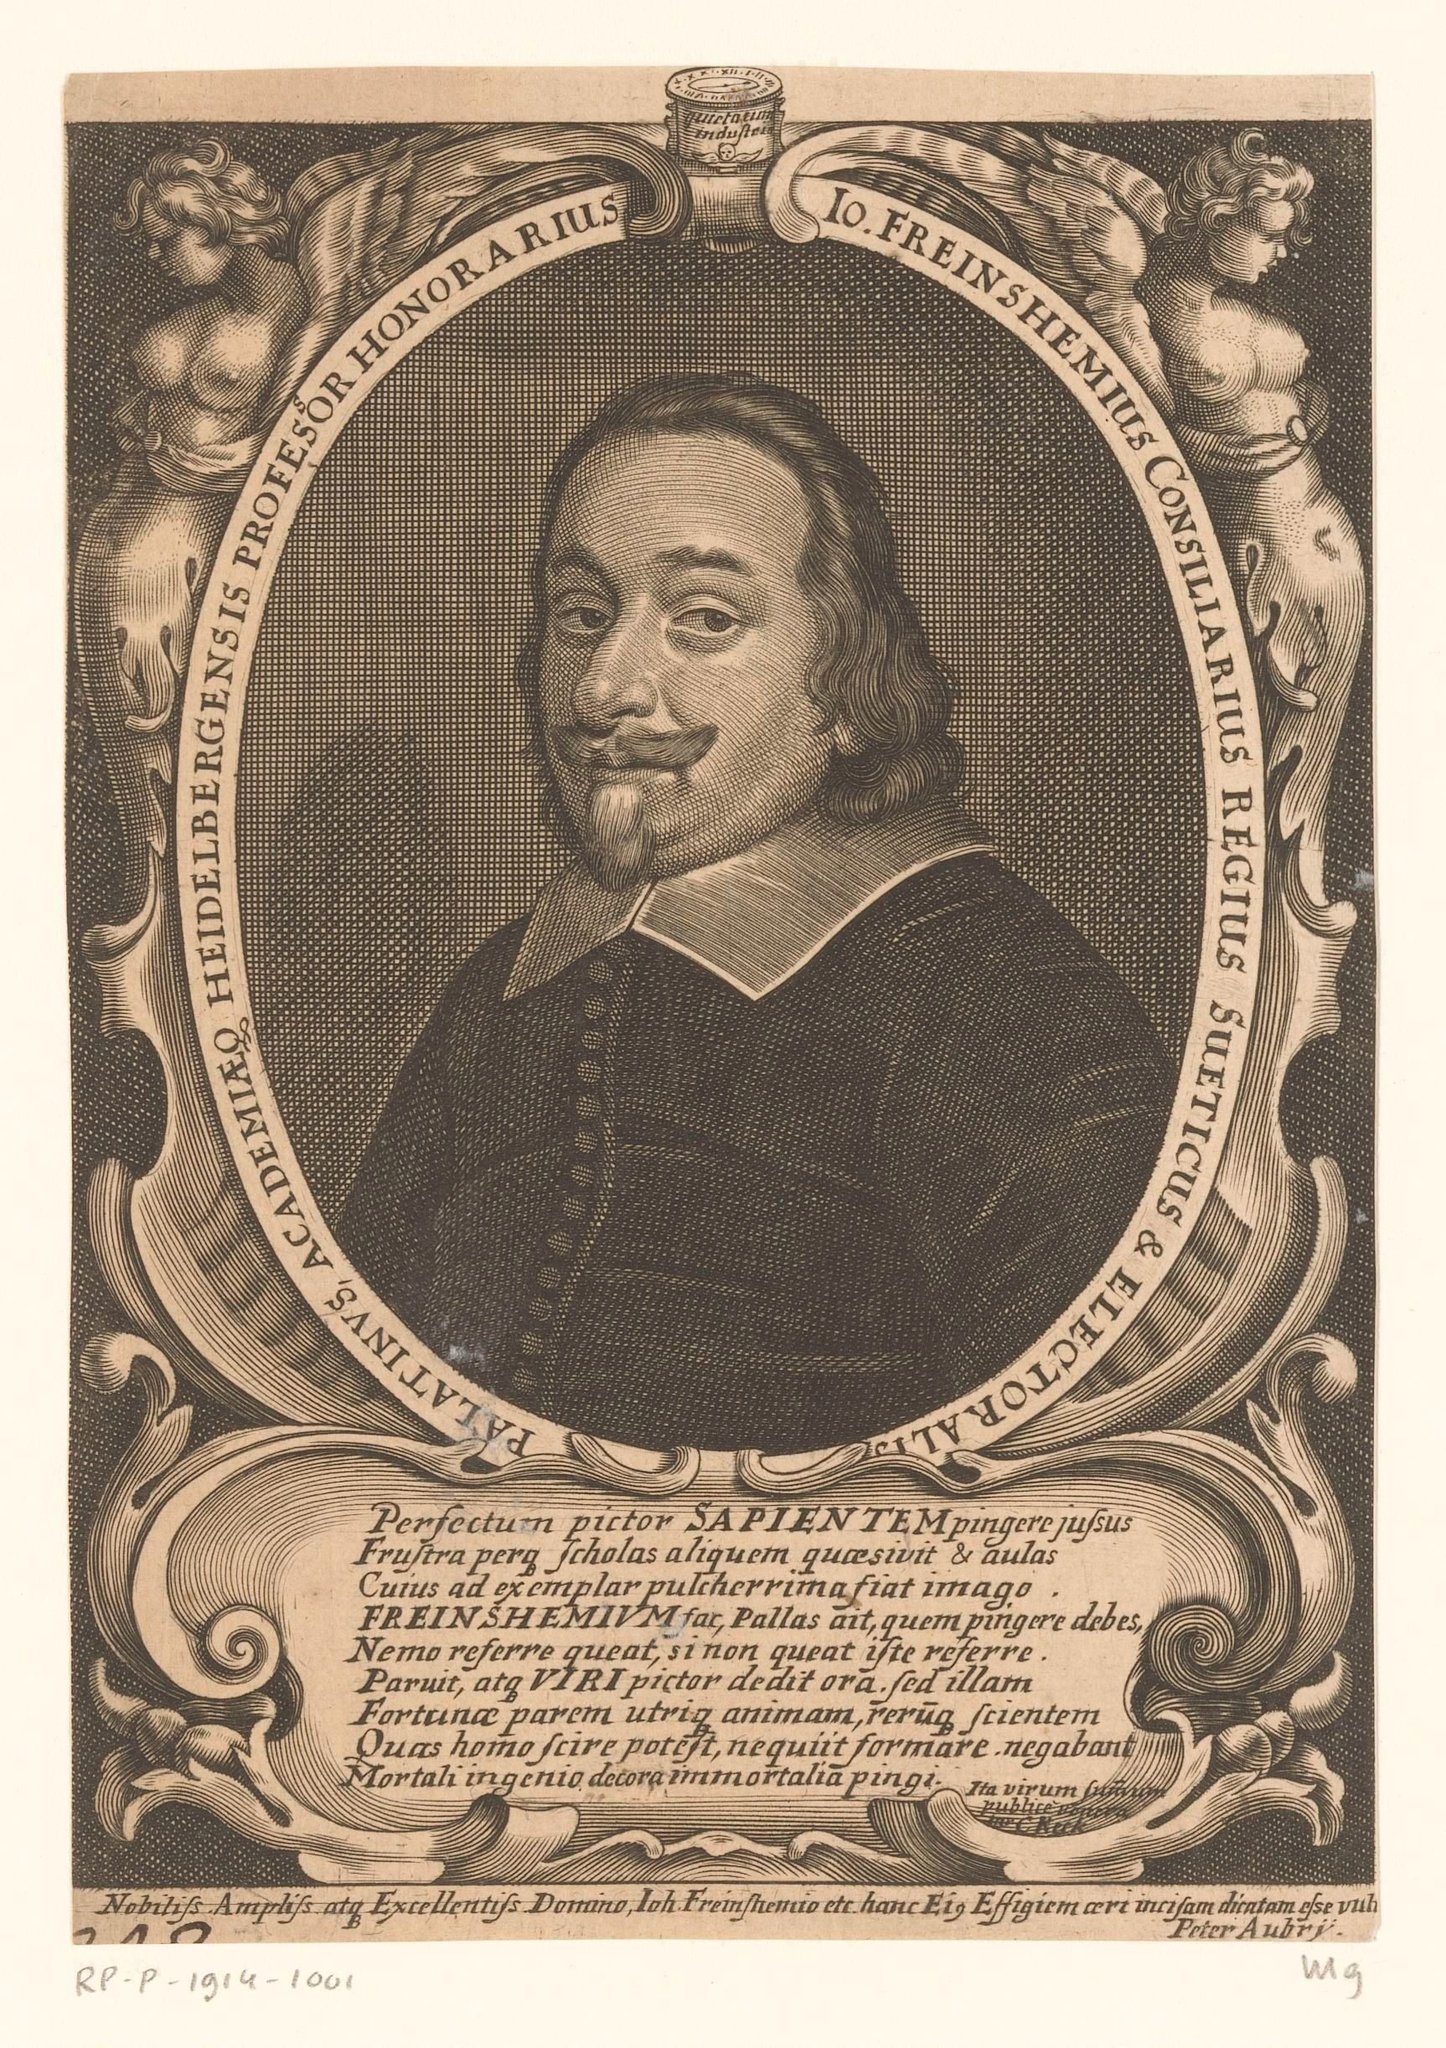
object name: print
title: Portret van Marquard Freher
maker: peter aubry (ii)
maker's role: print maker, publisher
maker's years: 1596-1668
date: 1606-1666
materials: paper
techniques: engraving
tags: augsburg, historical persons, lawyer, attorney at law, diplomacy, diplomat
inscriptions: collector's mark: Lugt 2228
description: Met drieregelig onderschrift in het Latijn.